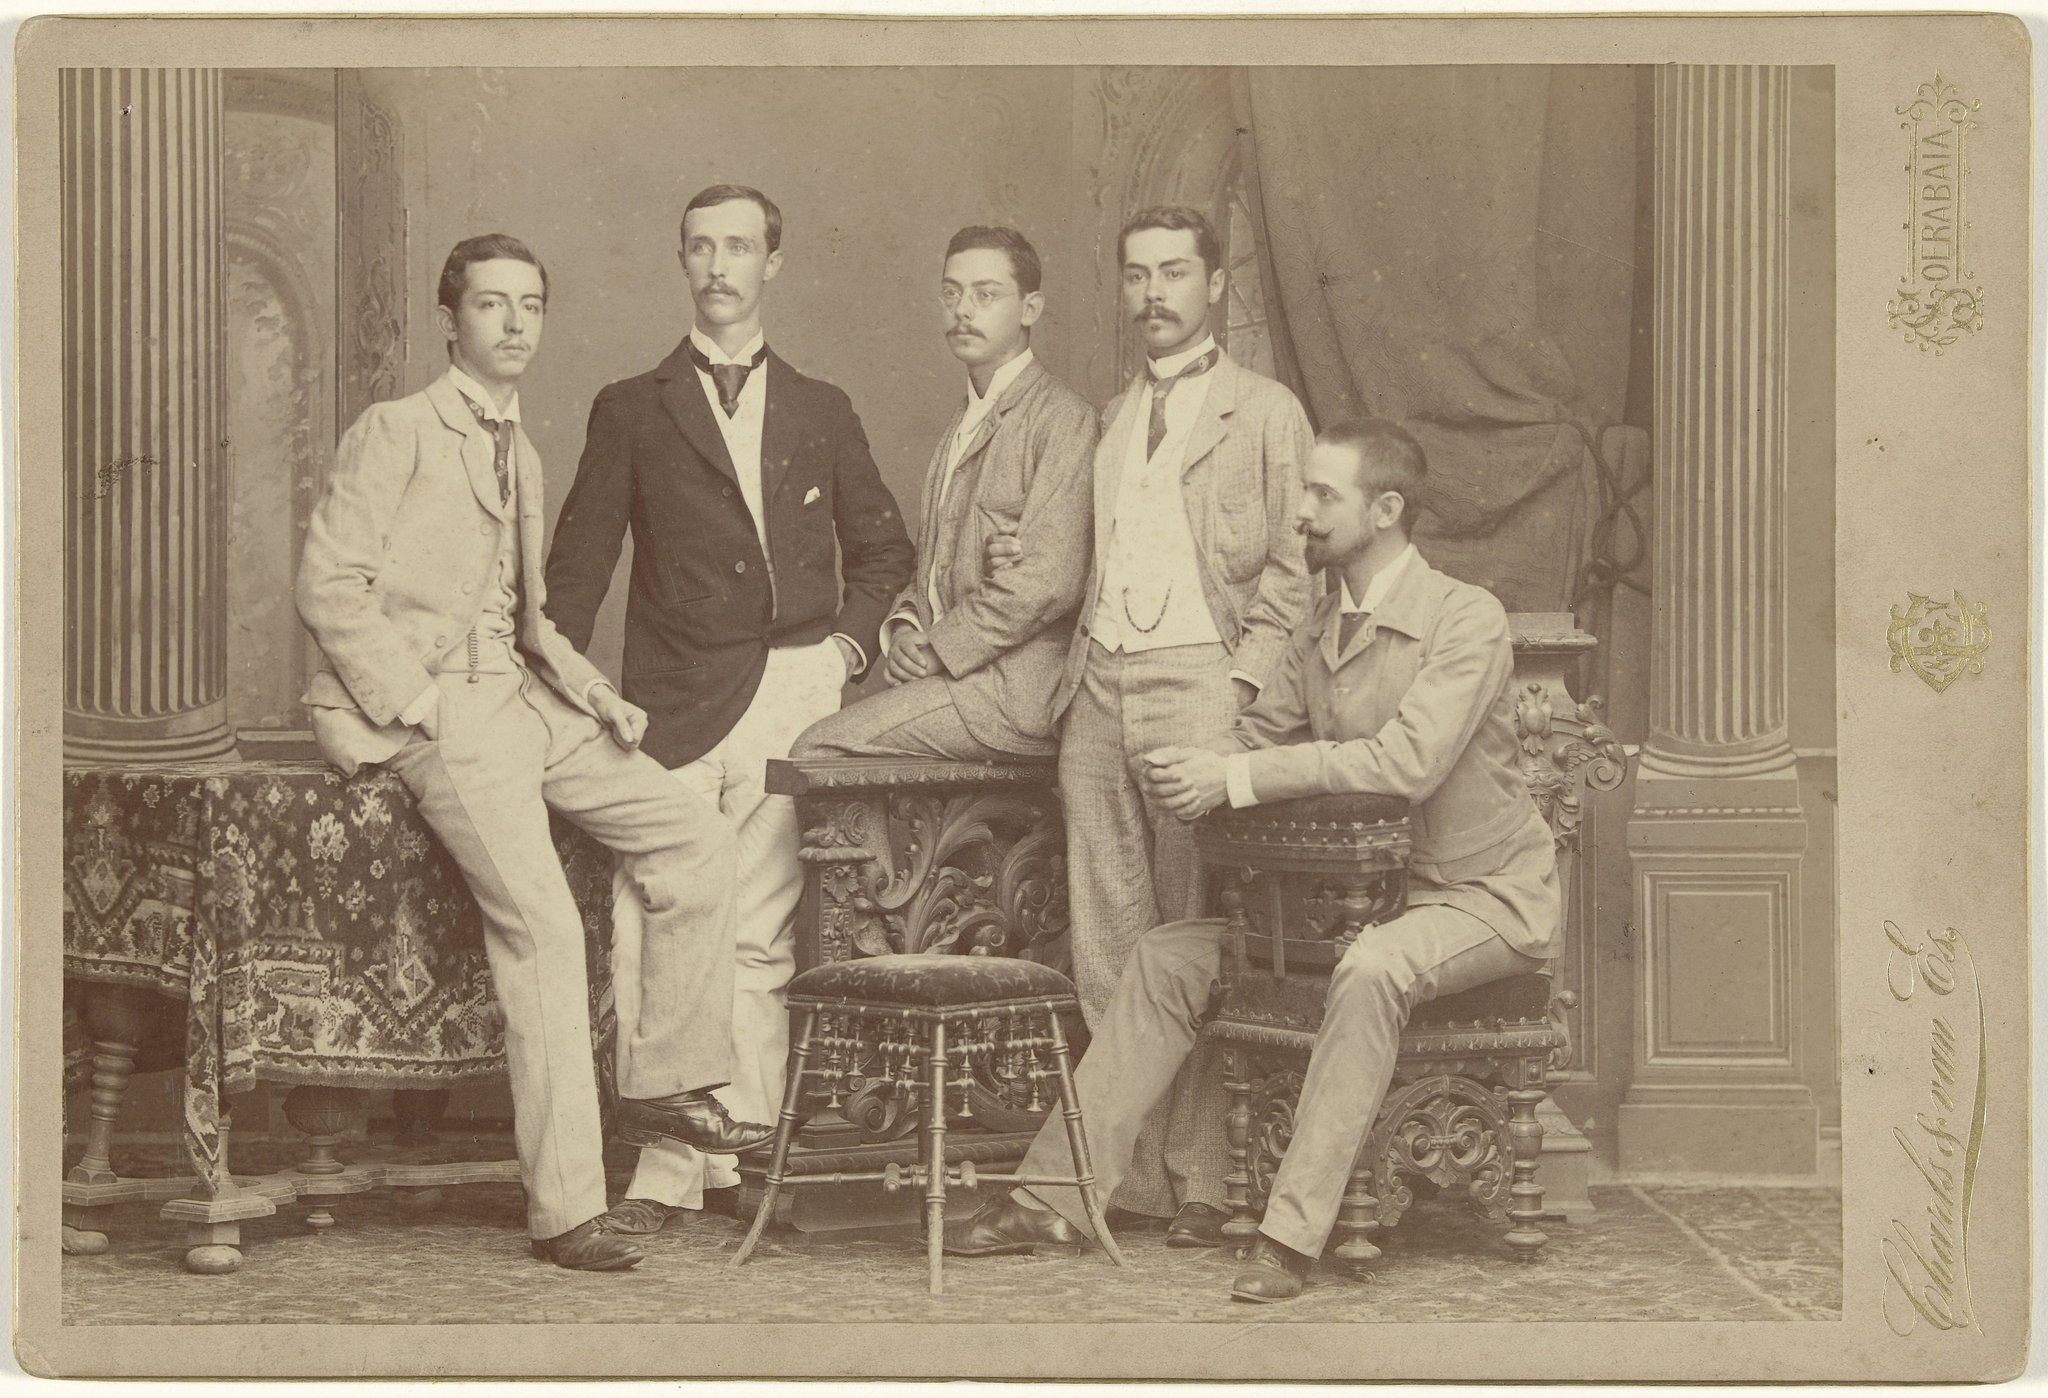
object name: photograph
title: Studioportret van vijf onbekende jongemannen, aangeduid als de zonen van Bouricius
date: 1884-1887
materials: cardboard, paper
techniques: albumen print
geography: surabaya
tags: adult man, historical persons, surabaya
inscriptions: inscription: ‘Jacques Baurien[?] 2de van links/ de 4 zoons van L.G.B. en Badina Bouricius’, inscription: ‘Charls & van Es/ Soerabaia’, inscription: ‘Photographie/ Instantanée/ Charls & van Es/ Soerabaia/ Specialiteit in Vergrootingen’